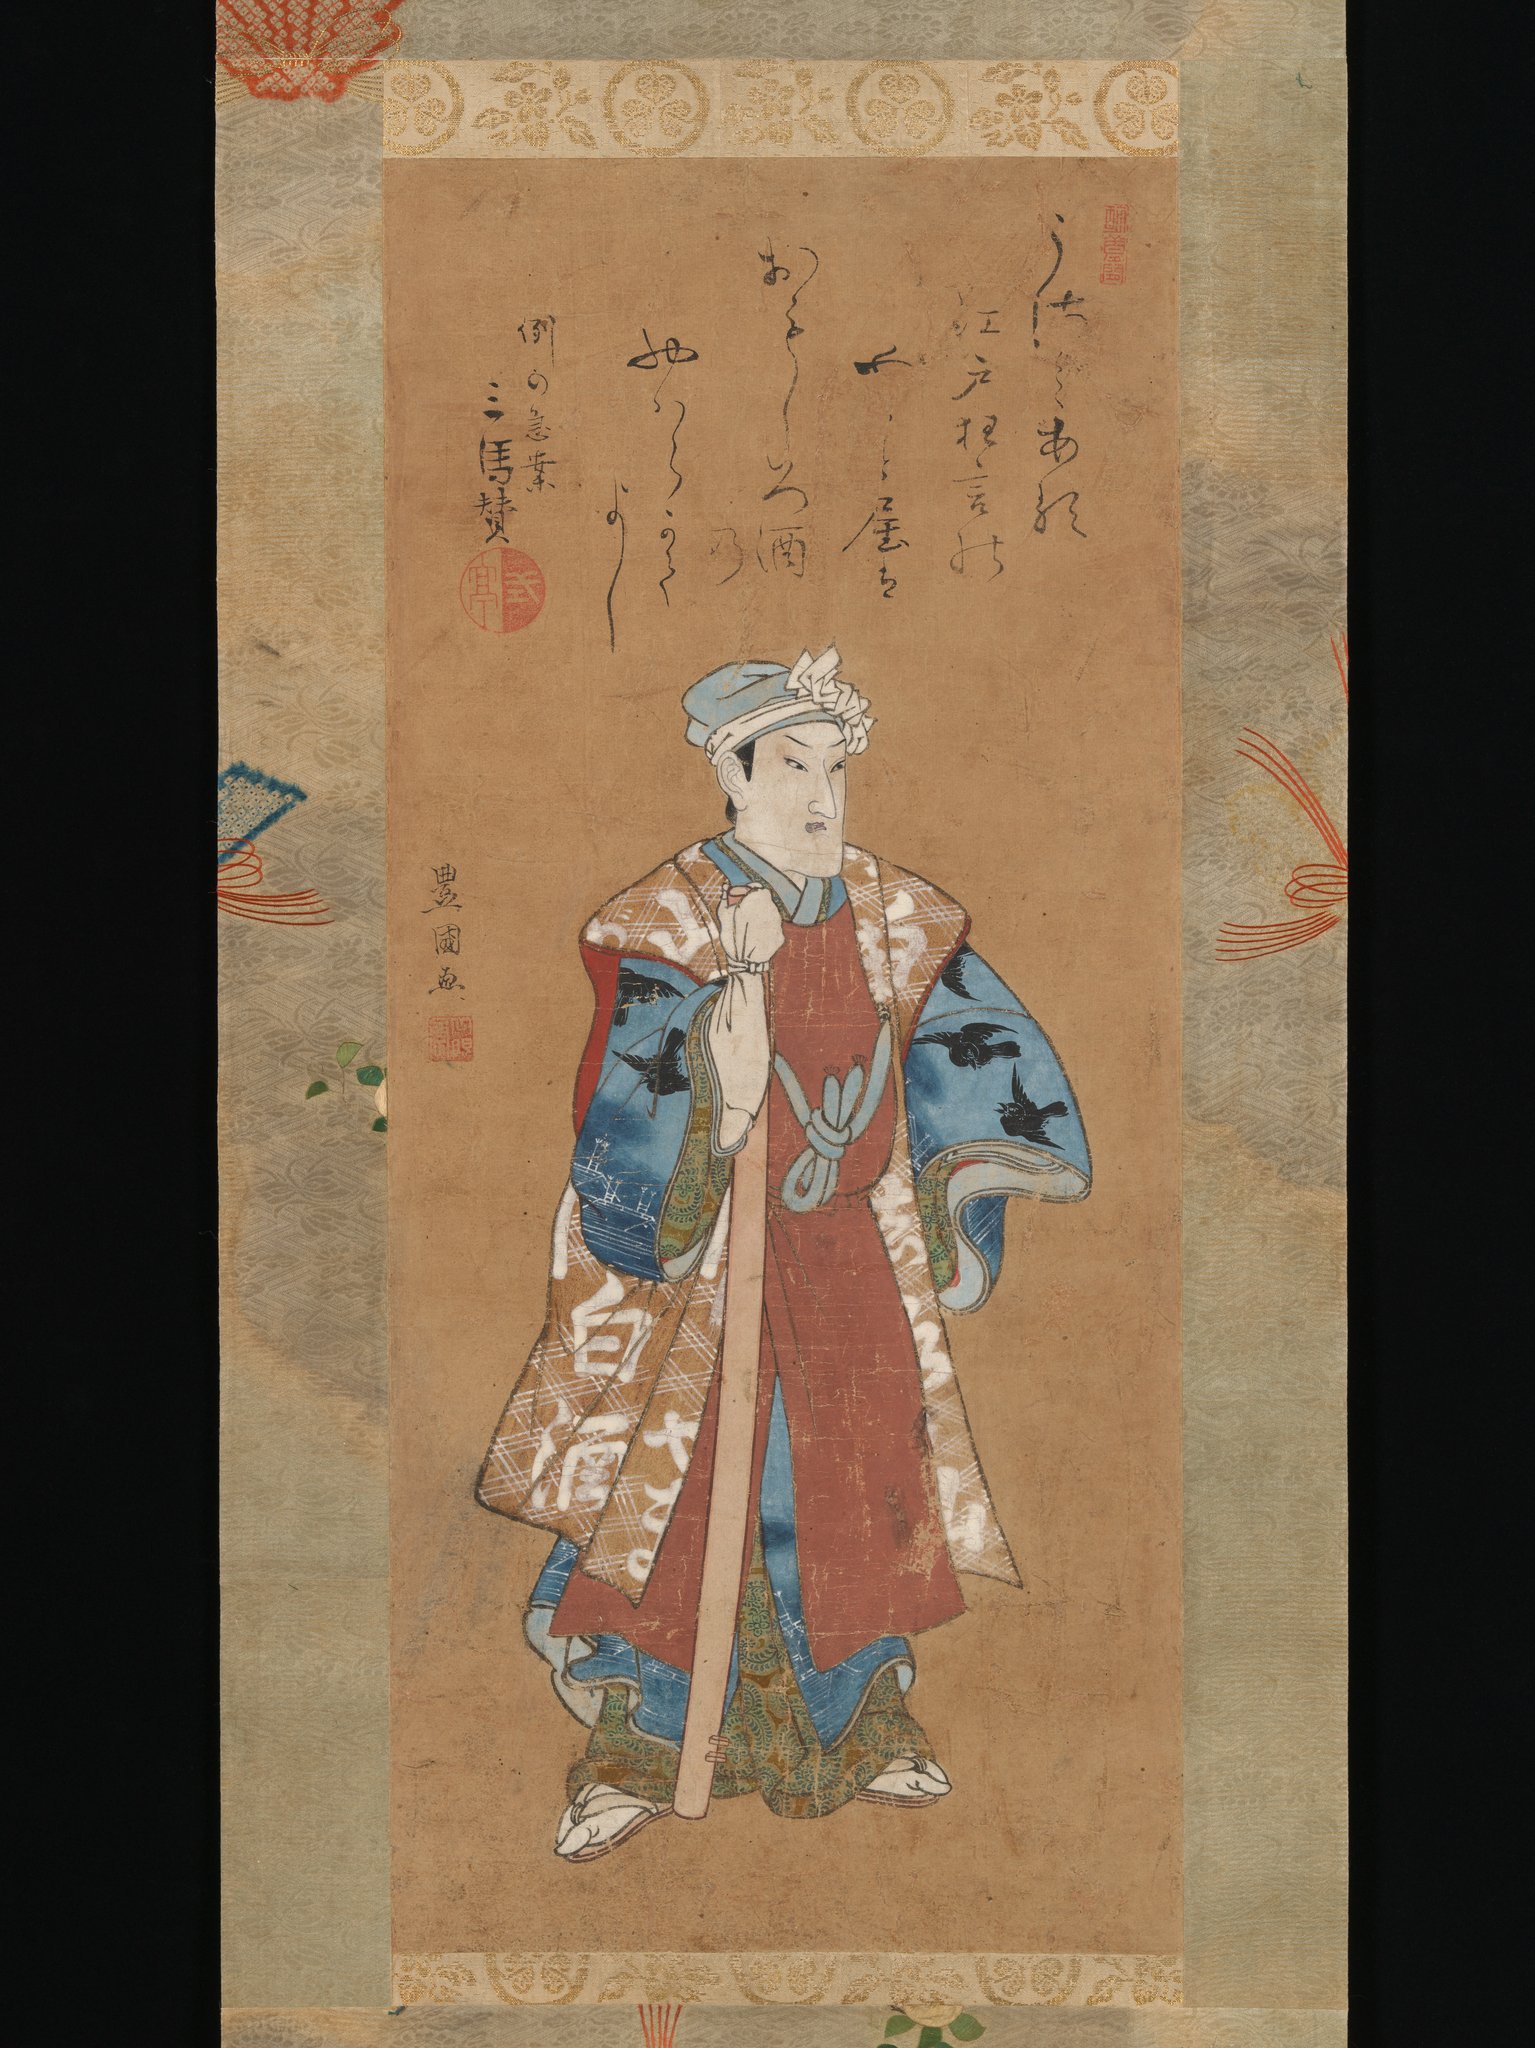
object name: hanging scroll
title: Bandō Mitsugorō II as Shinbei in the Kabuki Play "Sukeroku"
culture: japanese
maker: utagawa toyokuni i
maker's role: artist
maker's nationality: japanese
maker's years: 1769-1825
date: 1767-1833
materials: ink, paper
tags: men,actors